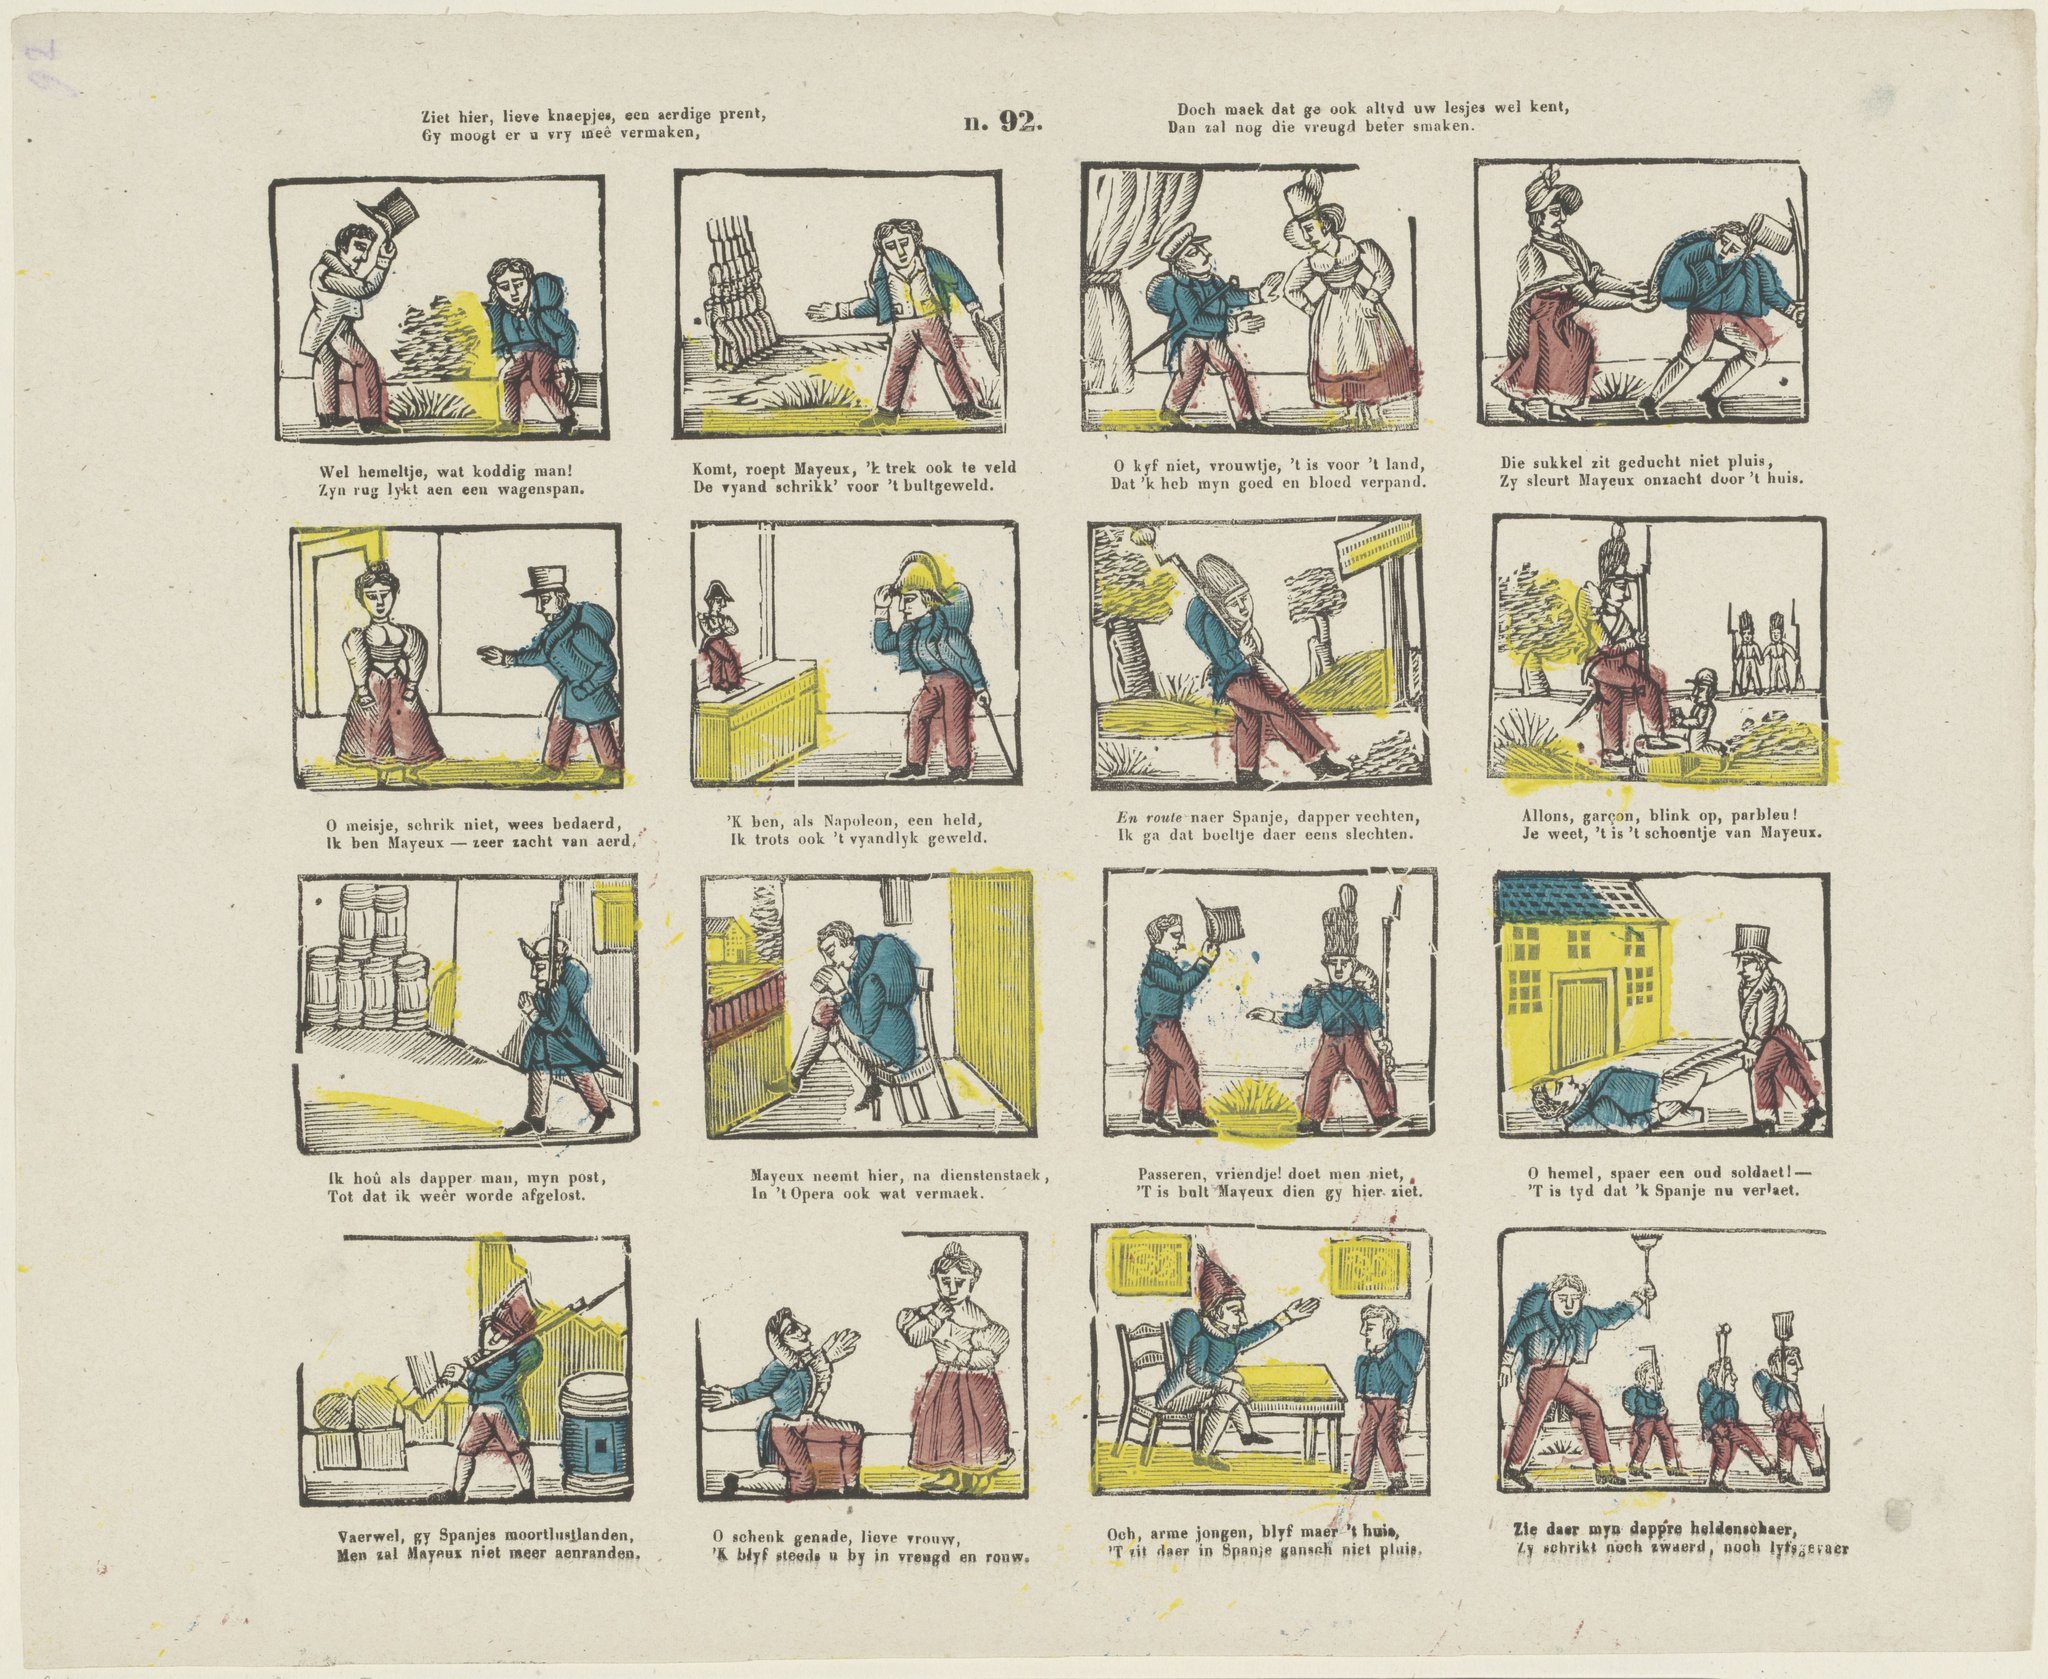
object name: popular print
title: Ziet hier, lieve knaepjes, een aerdige prent, / Gy moogt er u vry meê vermaken, / Doch maek dat ge ook altyd uw lesjes wel kent, / Dan zal nog die vreugd beter smaken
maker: Anonymous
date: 1833-1900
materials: paper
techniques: colour, letterpress printing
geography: netherlands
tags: caricatures (human types), hunchback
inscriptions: collector's mark: Lugt 2760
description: Blad met 16 voorstellingen over het leven van de gebochelde Mayeux. Onder elke afbeelding een tweeregelig vers. Genummerd midden boven: n. 92.